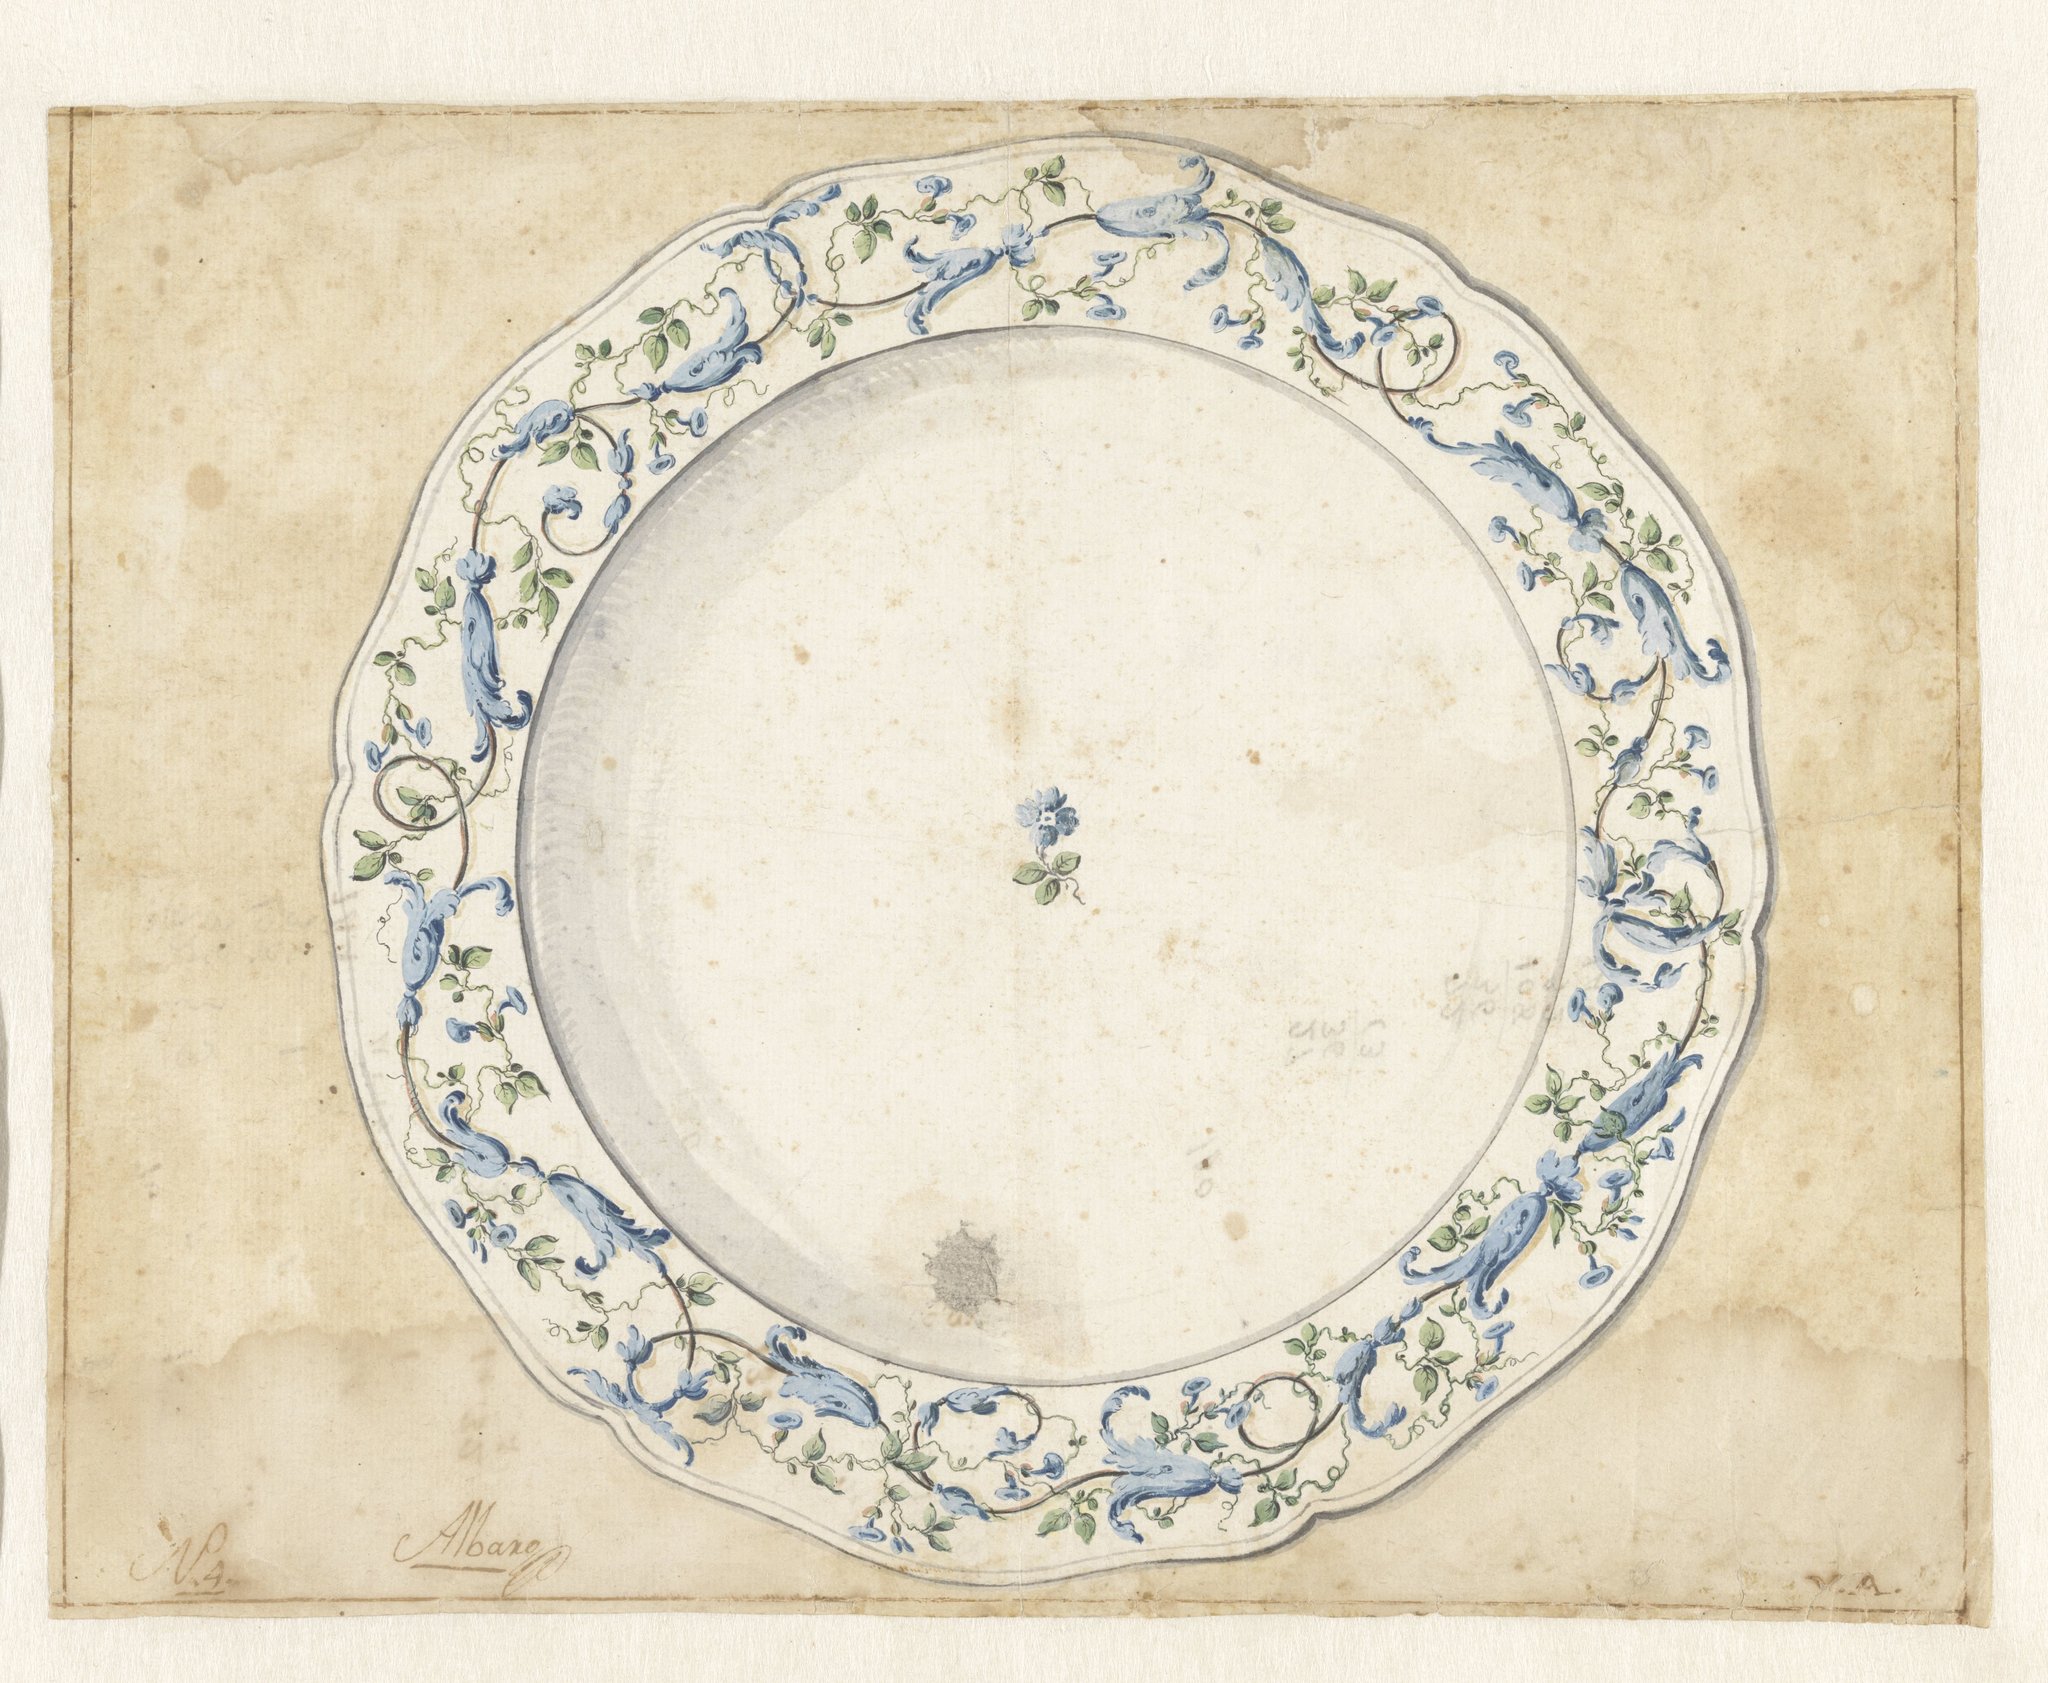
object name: watercolor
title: Ontwerp voor de decoratie van een porseleinen bord van de fabriek van Alcora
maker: vicente alvaro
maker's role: draughtsman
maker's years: 1752-1827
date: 1790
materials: ink, paper, watercolor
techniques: brush, pen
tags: dish, plate, saucer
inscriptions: inscription: ‘Manuela de Castro’, number: ‘No. 4’, signature: ‘Albaro’